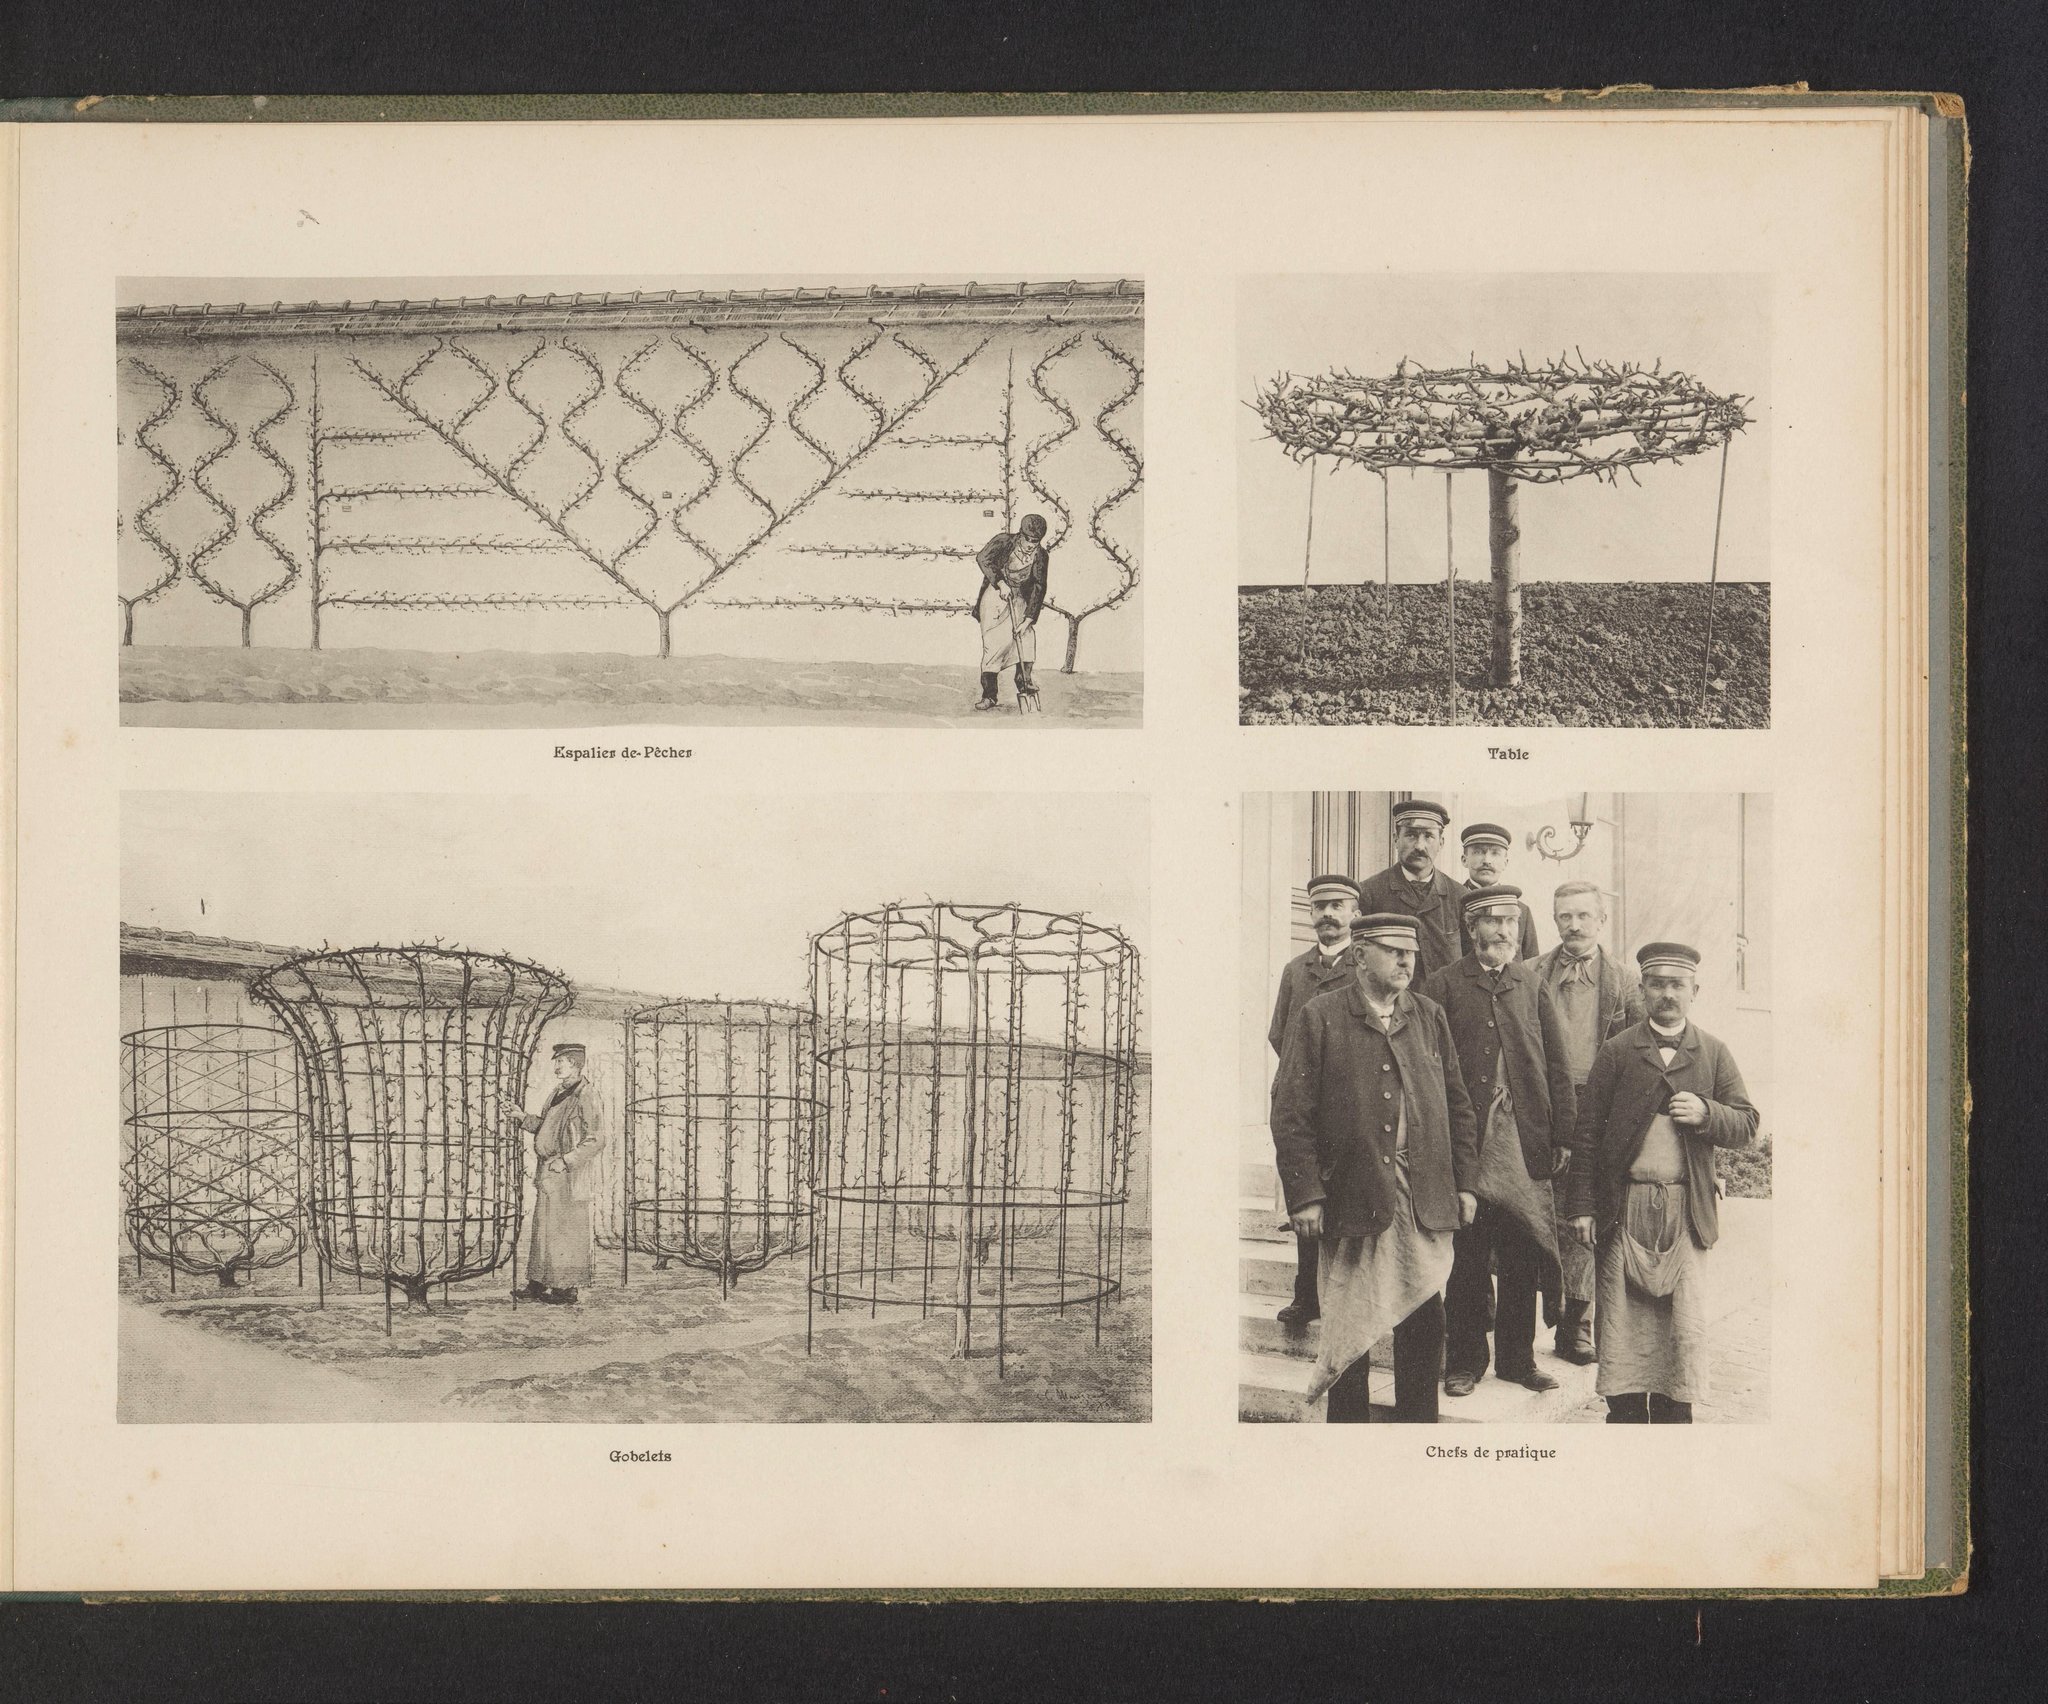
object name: photomechanical print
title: Espalier de Pêcher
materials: paper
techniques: photograph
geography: versailles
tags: horticulture, vegetable culture, market gardening, trees, anonymous historical persons portrayed in a group, in a group-portrait